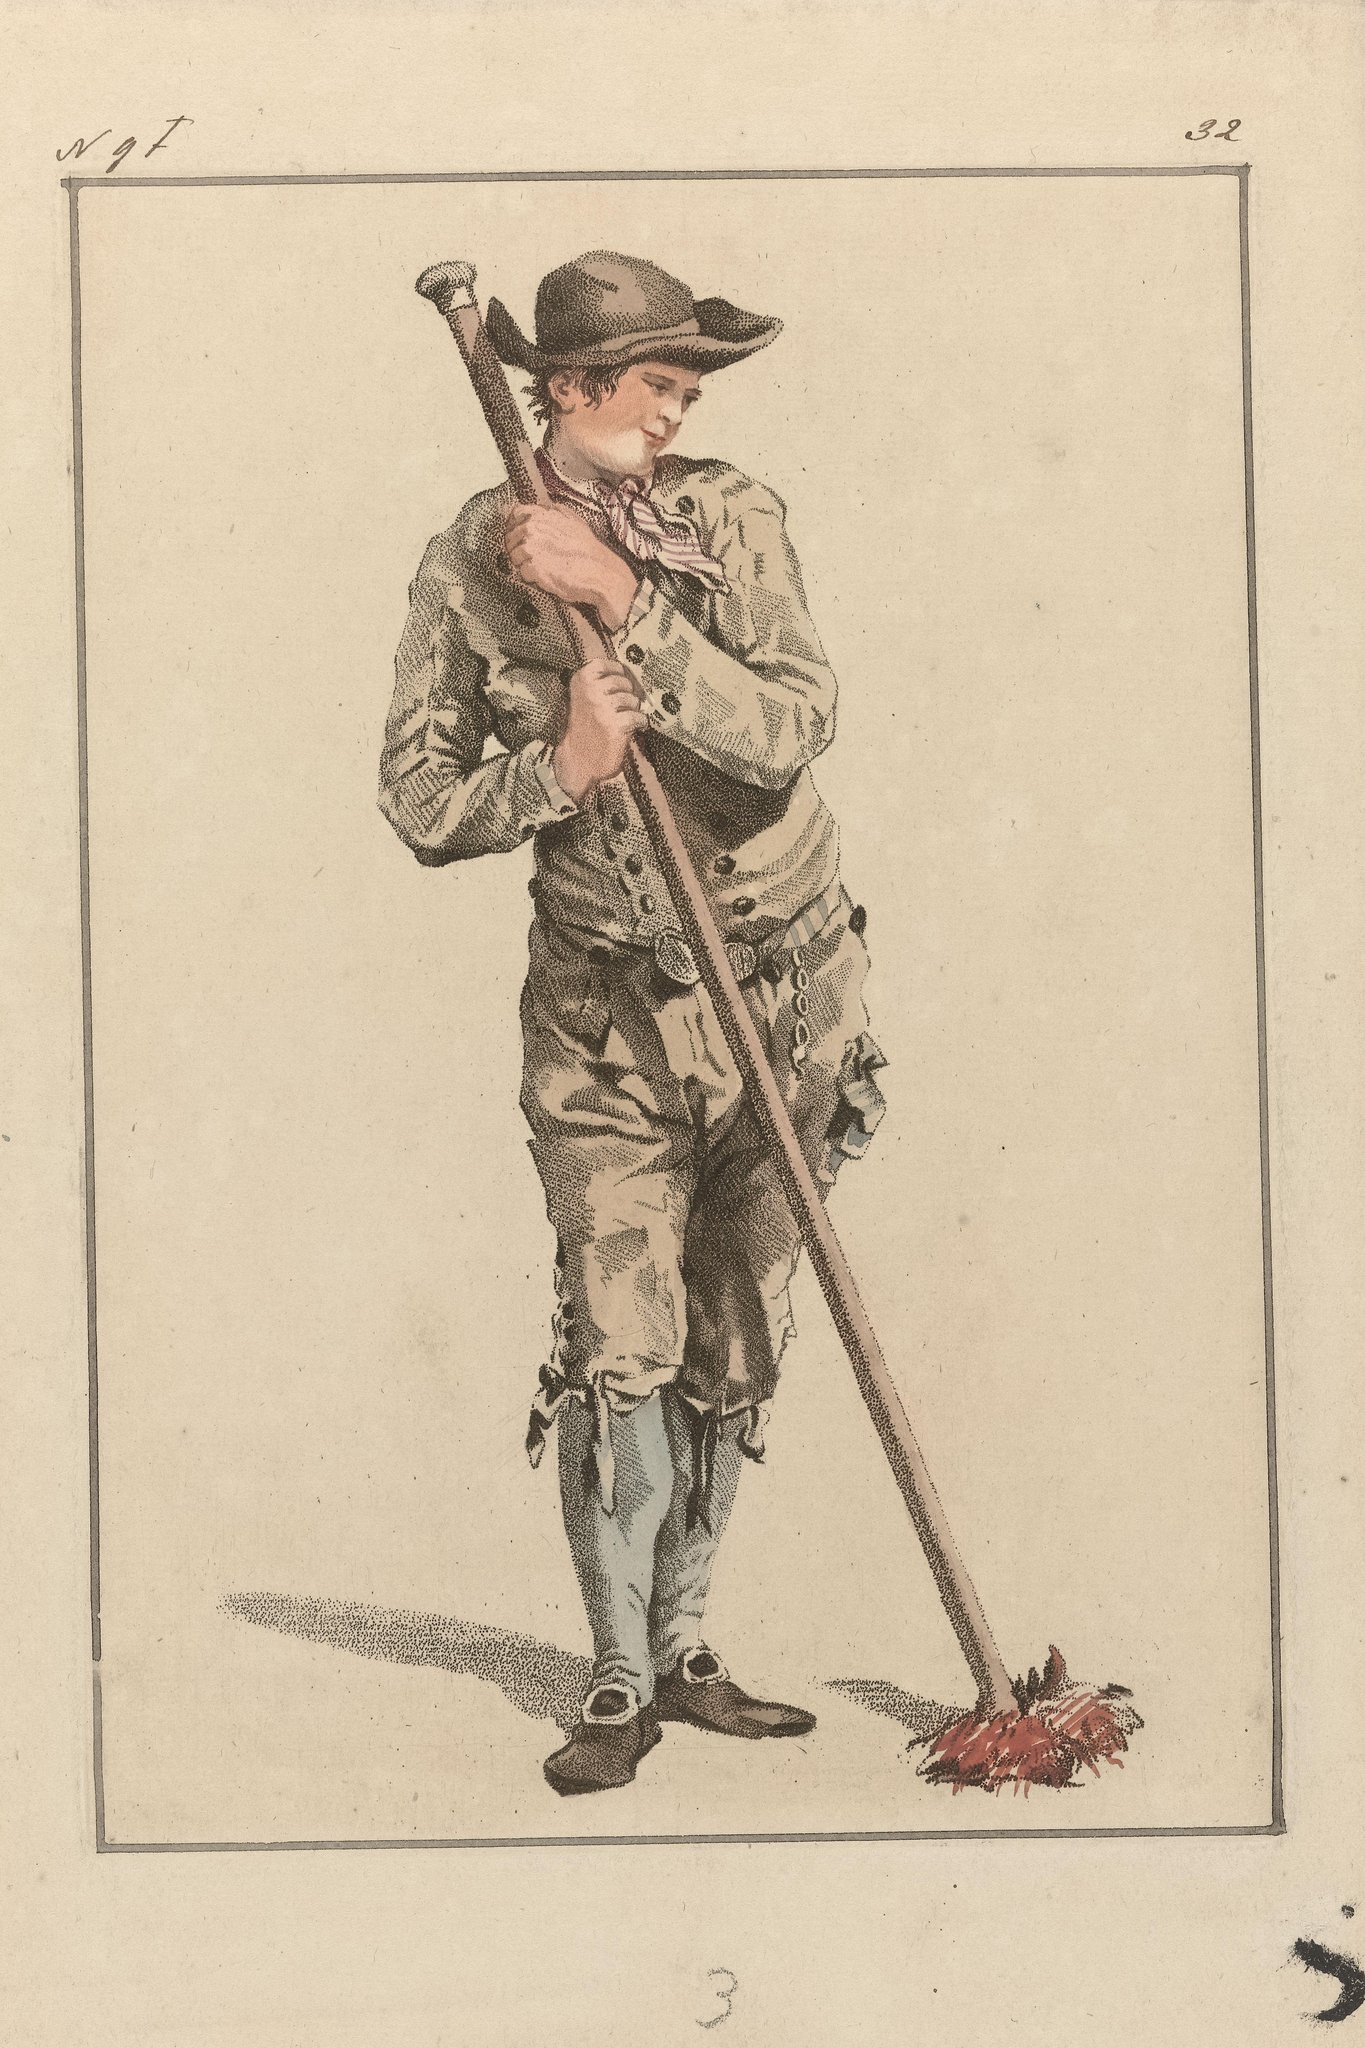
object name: print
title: Schoorsteenveger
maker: mathias de sallieth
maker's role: print maker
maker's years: 1749-1791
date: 1772-1791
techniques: printing, printmaking, hand coloring, lithography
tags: adult man, head-gear: hat (+ men's clothes), handicrafts ~ maintenance and repair (with name of trade or profession)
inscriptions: collector's mark: Lugt 2228, number: ‘N 9 I - 32’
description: De prent verscheen vanaf 1818 tevens als onderdeel van een 33-delige reeks prenten door Mathias de Sallieth, samengebonden in: Perkois, Jacobus, Prins, Johannes Huibert. Verzameling van verschillende gekleede mans- en vrouwenstanden, ter oefening van jonge schilders en liefhebbers. Rotterdam: Johannes Immerzeel, 1818.